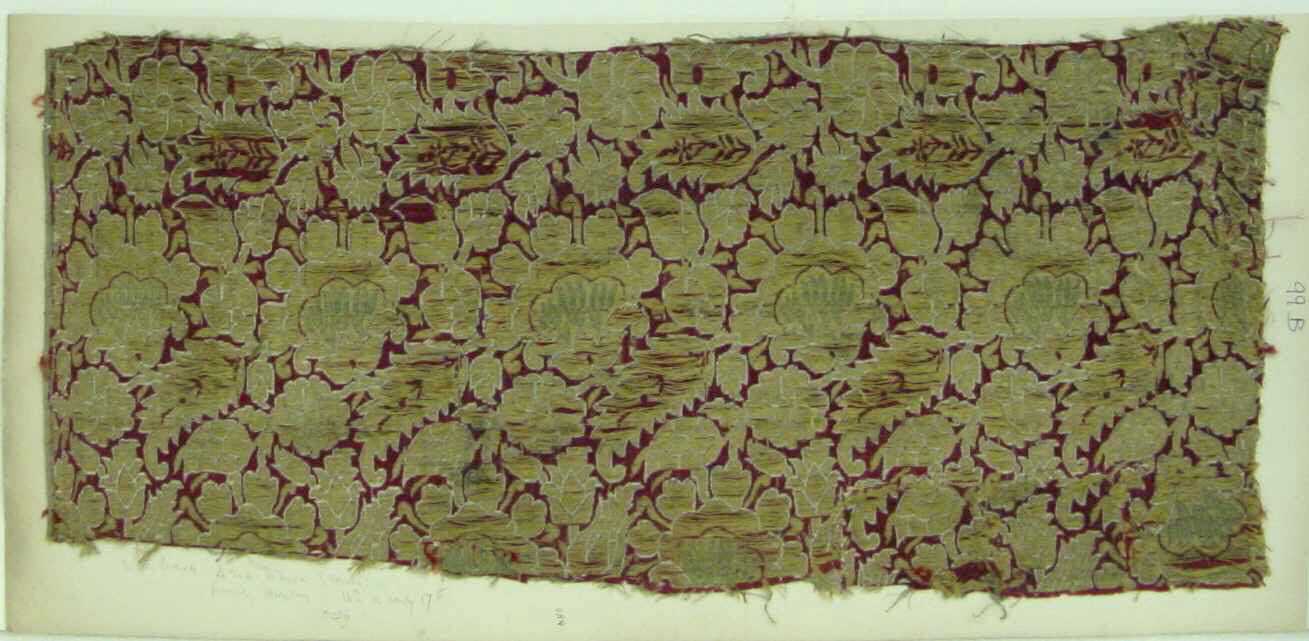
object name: textile fragment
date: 1501-1700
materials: metal thread, silk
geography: turkey